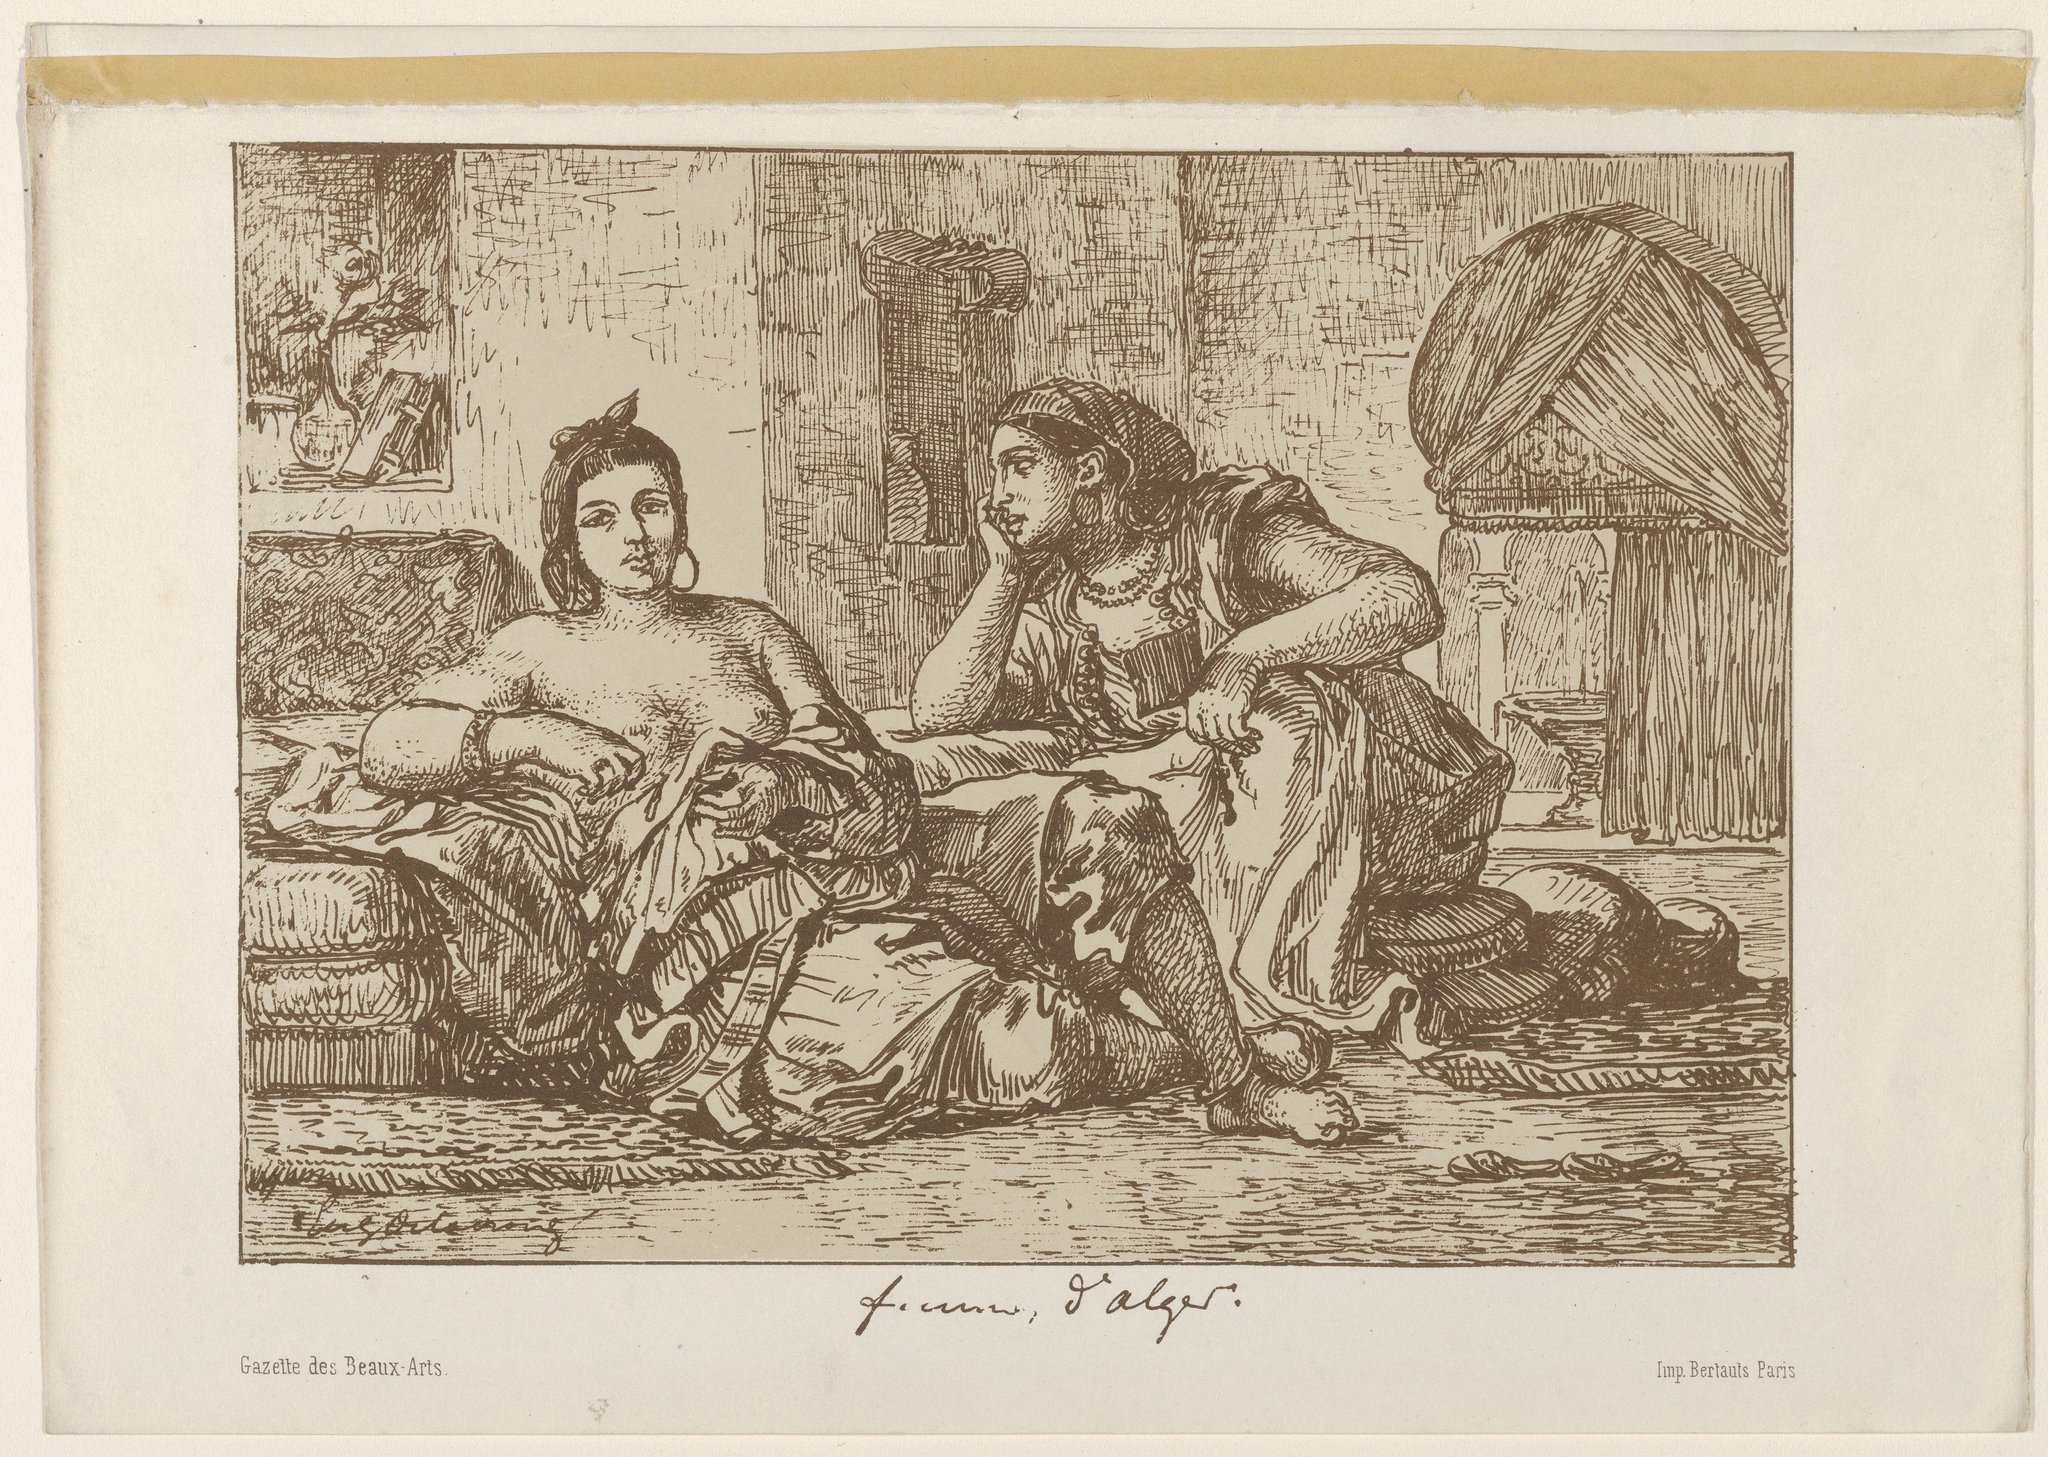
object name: print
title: Women of Algiers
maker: eugène delacroix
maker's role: artist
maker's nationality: french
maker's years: 1798-1863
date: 1833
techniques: lithograph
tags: women